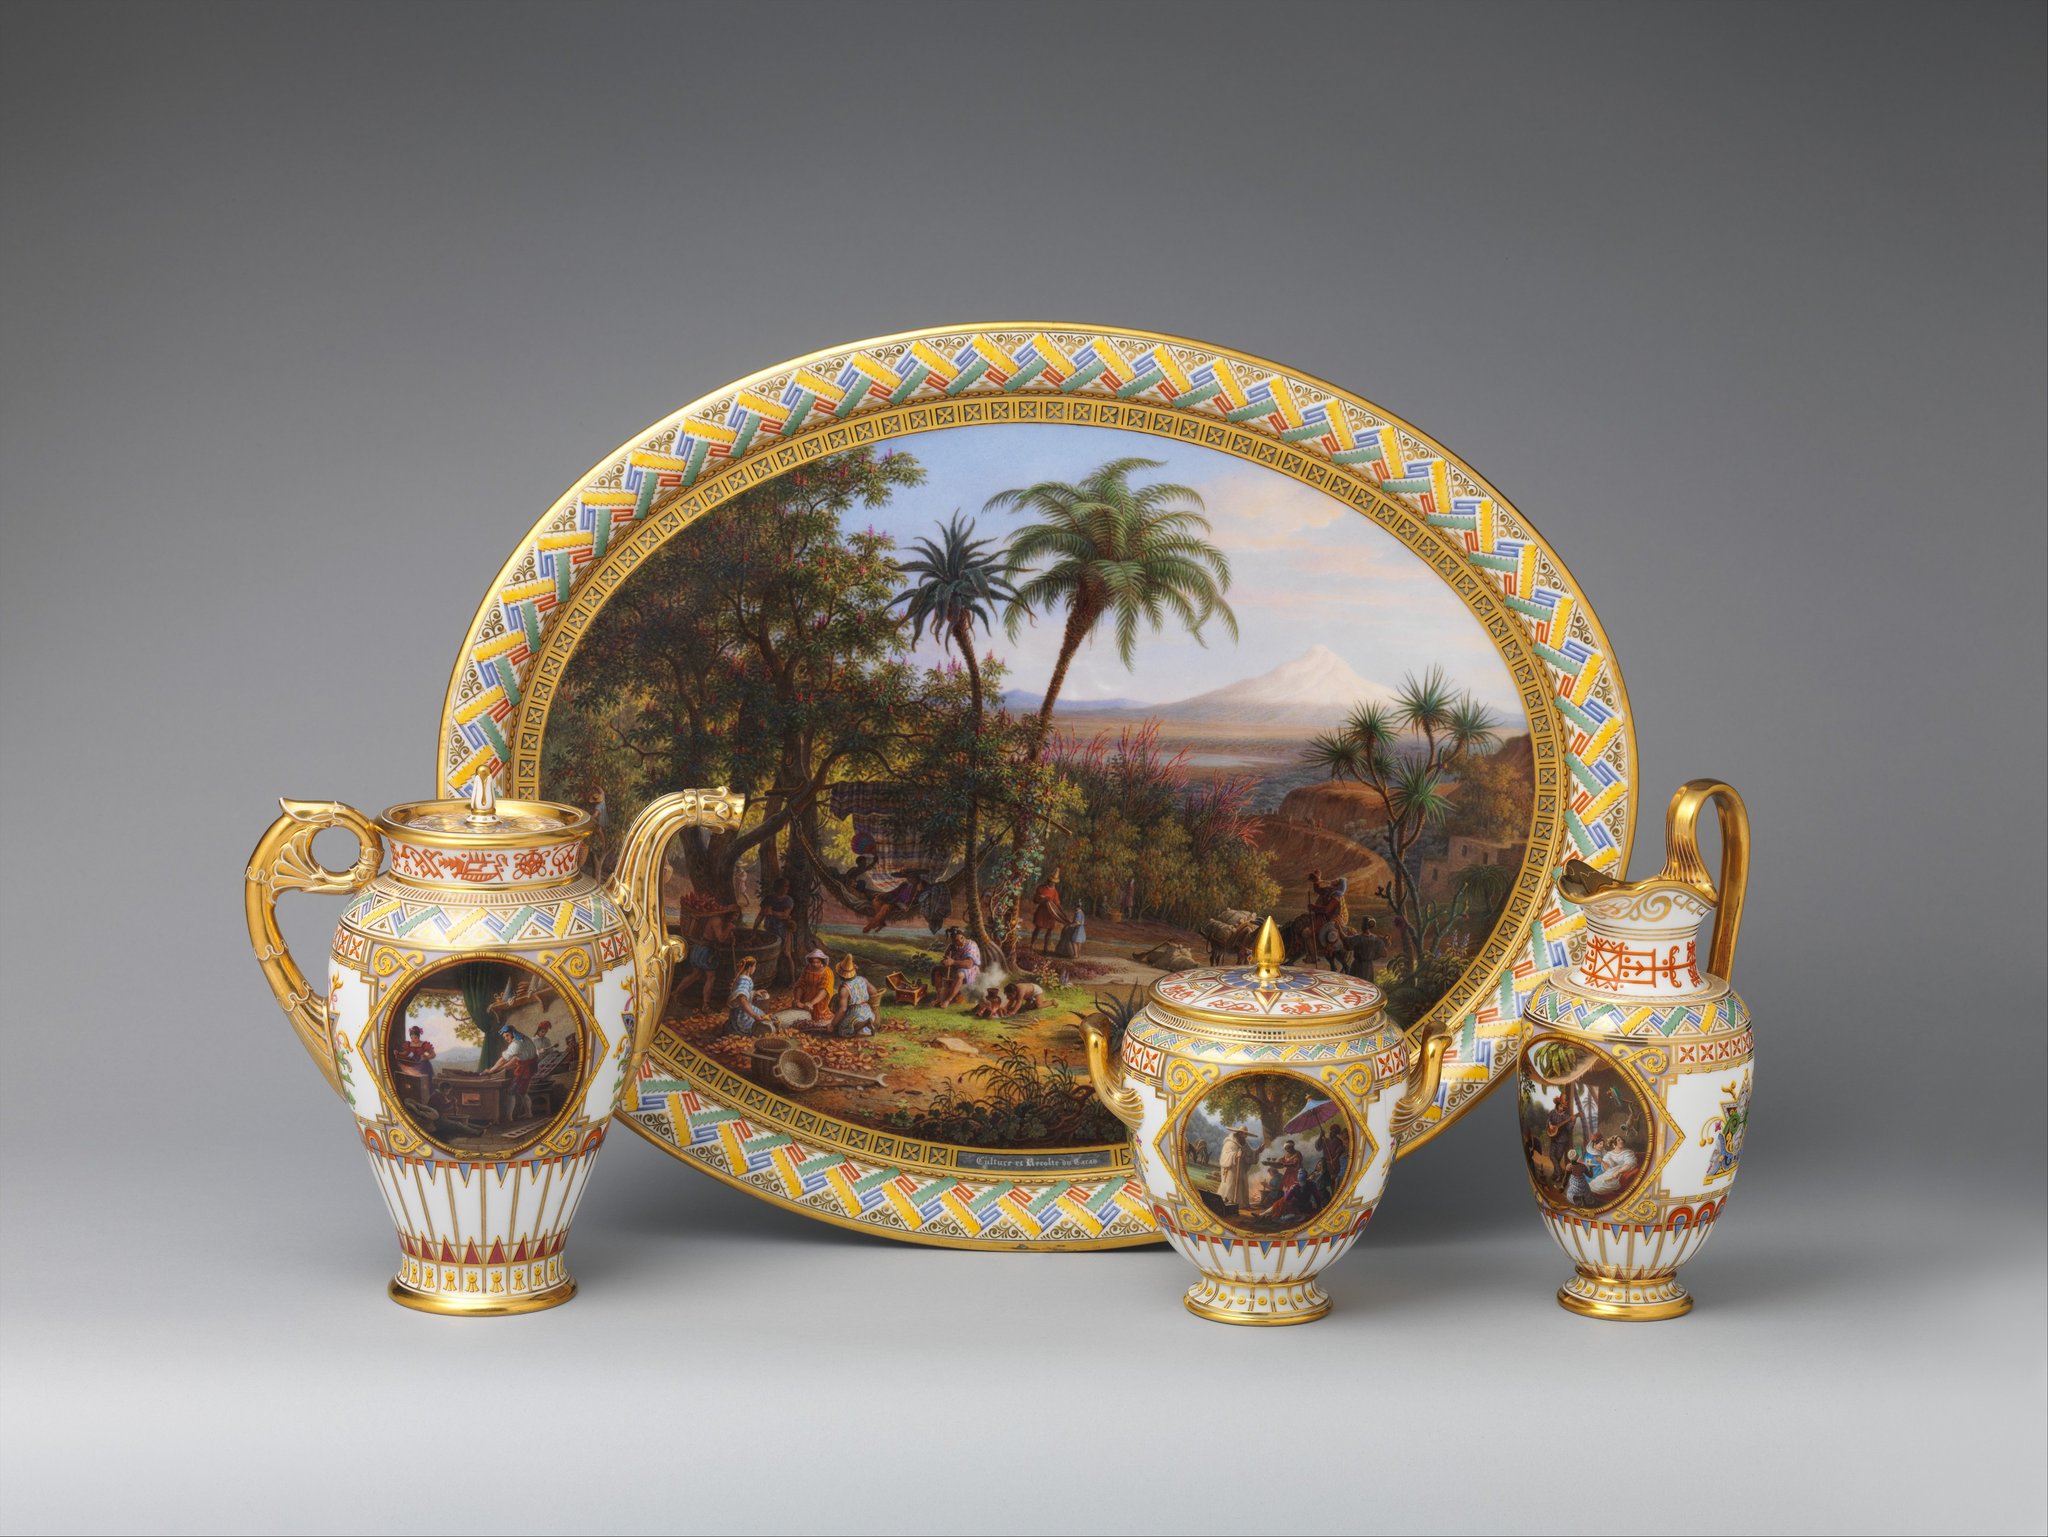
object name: coffee service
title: Partial coffee service (Déjeuner “Culture et Récolte du cacao”)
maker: sèvres manufactory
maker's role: manufactory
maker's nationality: french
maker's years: 1740-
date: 1836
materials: enamel, gold, hard paste porcelain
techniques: polychrome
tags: men,women,landscapes,industry